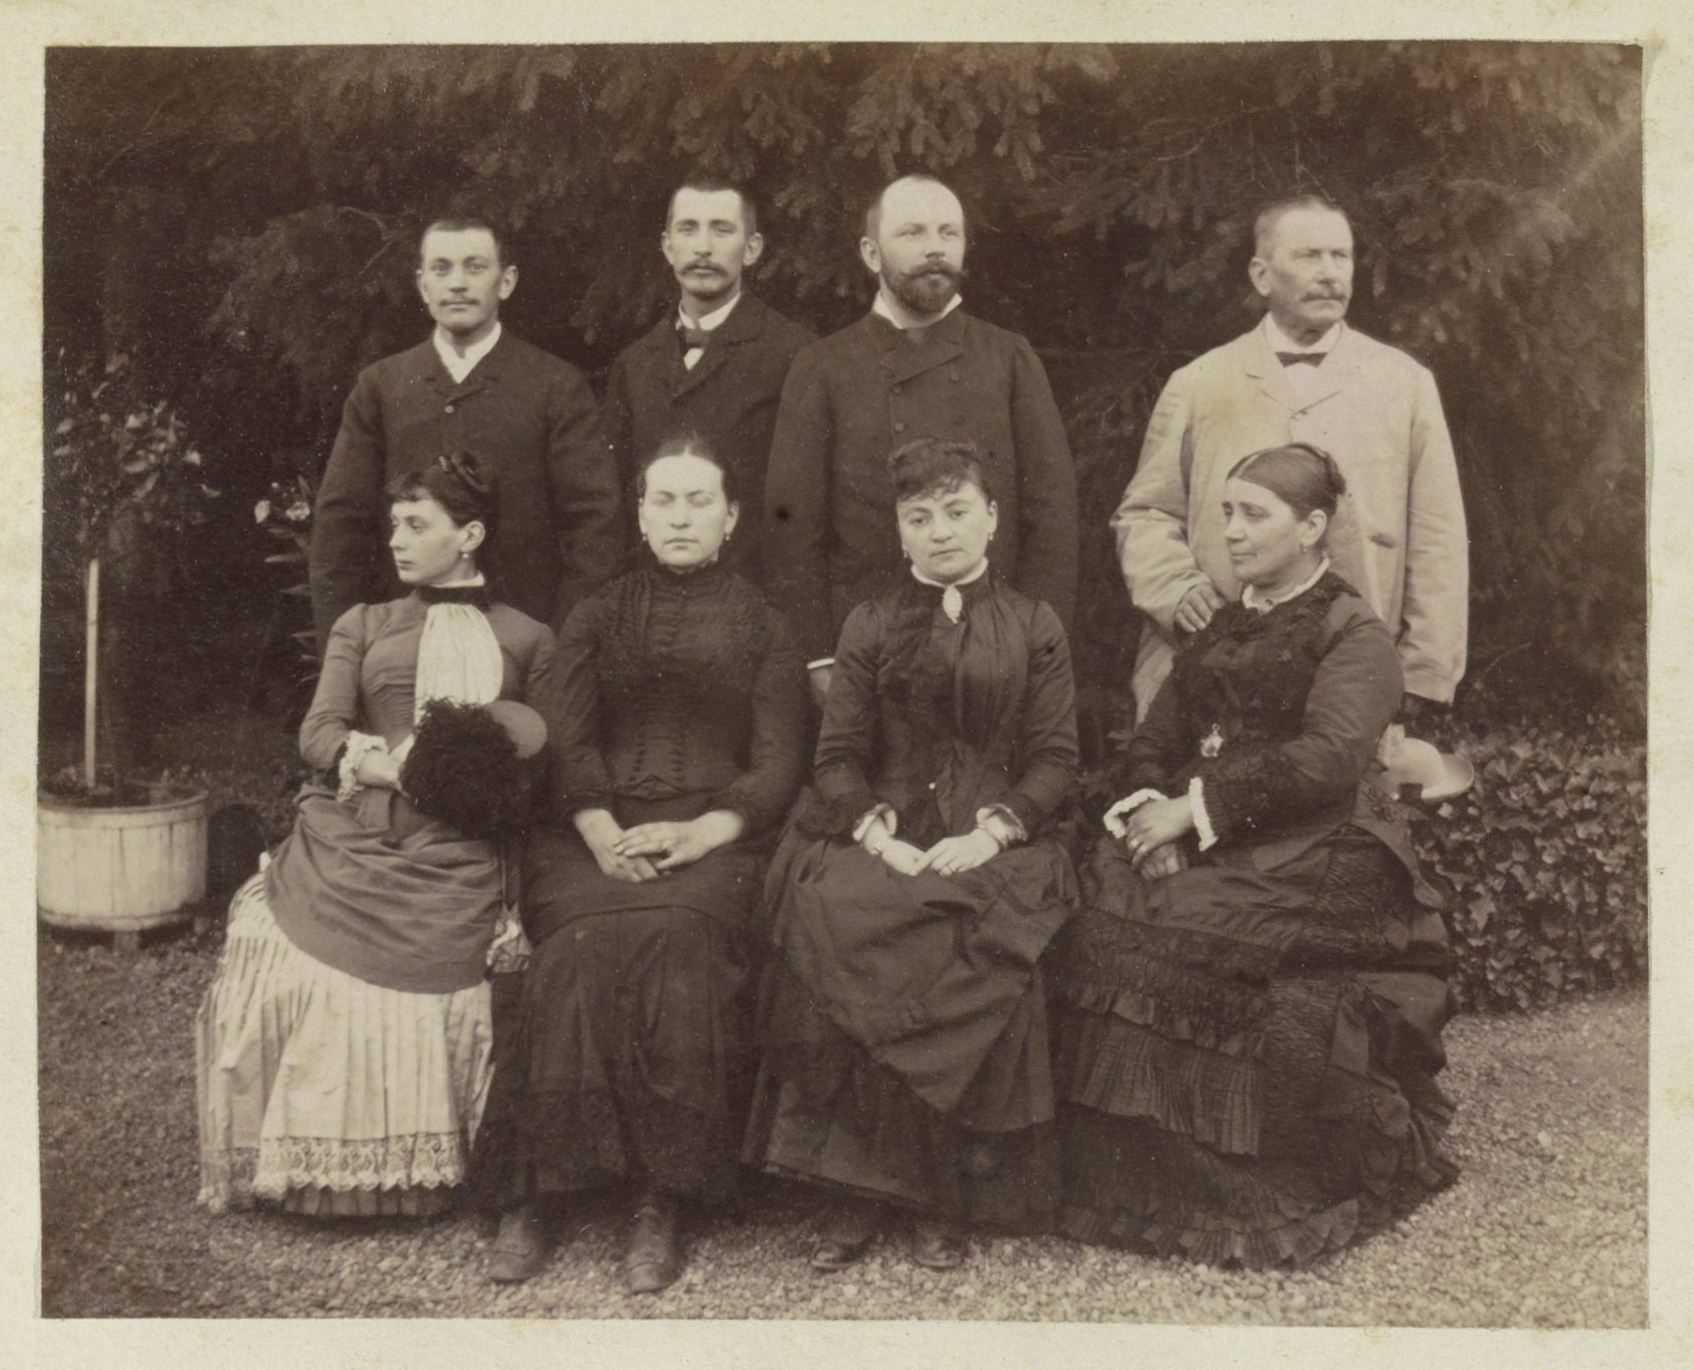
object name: photograph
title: Groepsportret van een Franse familie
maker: Anonymous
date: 1808-1885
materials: photographic support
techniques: albumen print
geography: france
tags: family group, especially parents with their child(ren)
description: Onderdeel van Album van een Franse amateurfotograaf met opnames van familie, militairen, industrie, landschappen en bezienswaardigheden in Frankrijk.